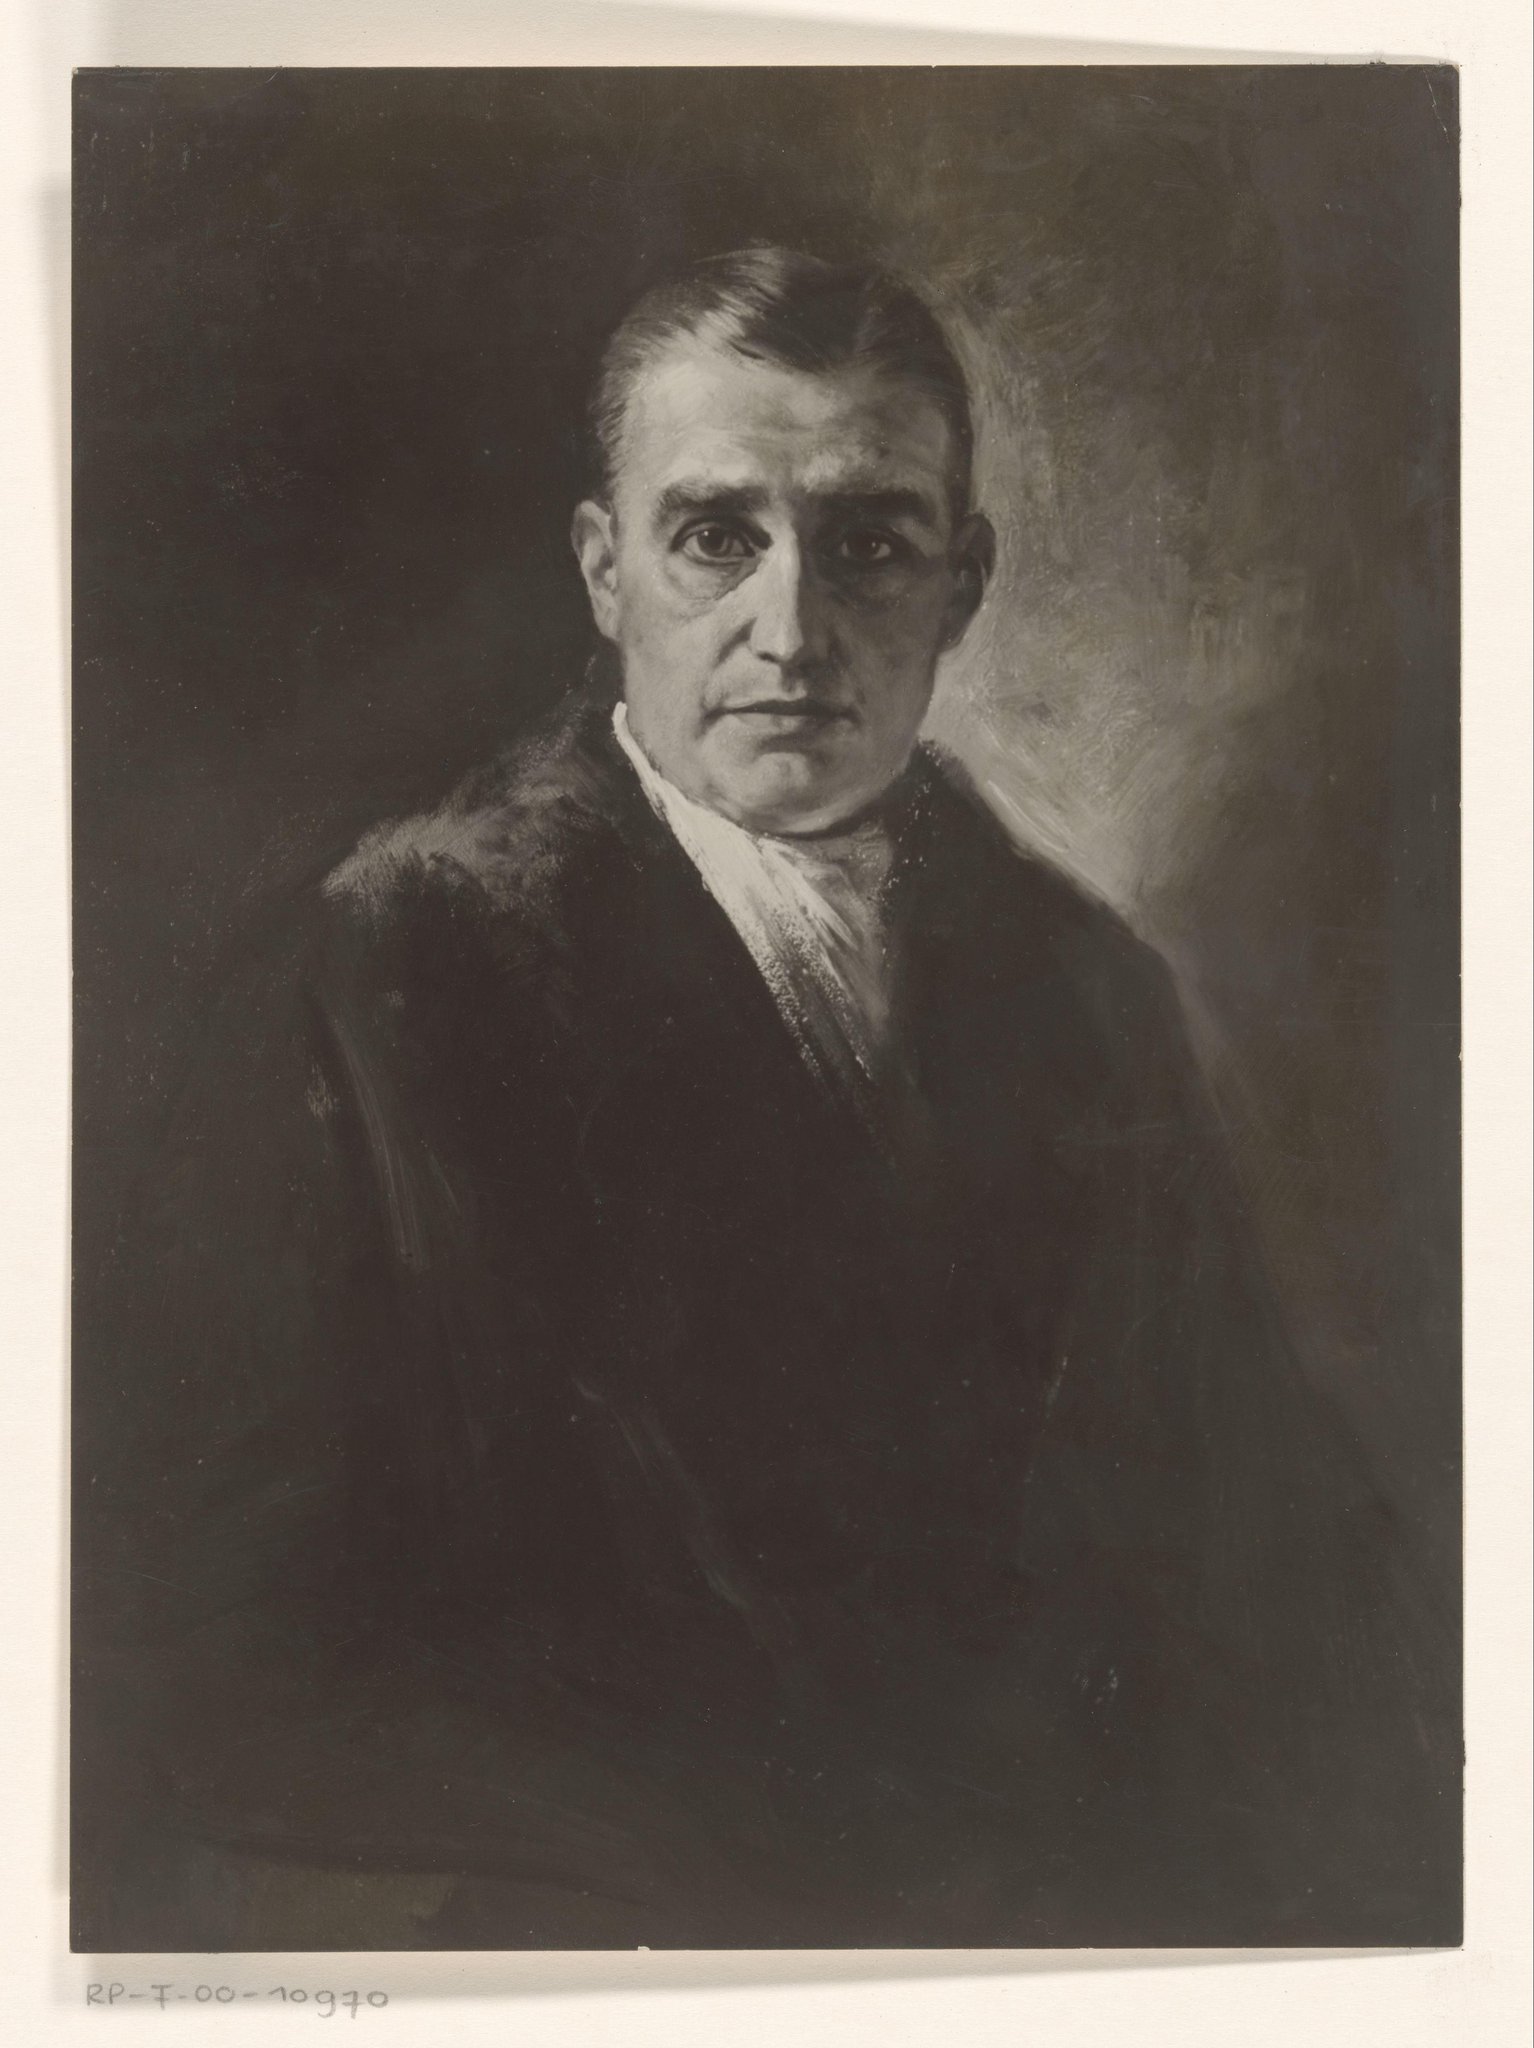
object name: reproduction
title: Fotoreproductie van een schilderij, voorstellende een portret van Henri van Wermeskerken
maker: Anonymous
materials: photographic support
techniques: gelatin silver print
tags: rotterdam, portrait of a writer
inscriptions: annotation: ‘Voorin Ind. Binnehuijsje/ onderschrift:/ Henri van Wermeskerken/ (naar een schilderij va[sic] H. van Meegeren)/ v Veen A'dam’, number: ‘7419’, collector's mark: Lugt 2228a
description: Portret bedoeld om opgenomen te worden in: Wermeskerken, Henri van. Een Indisch binnenhuisje. Amsterdam: Veen, 1929.